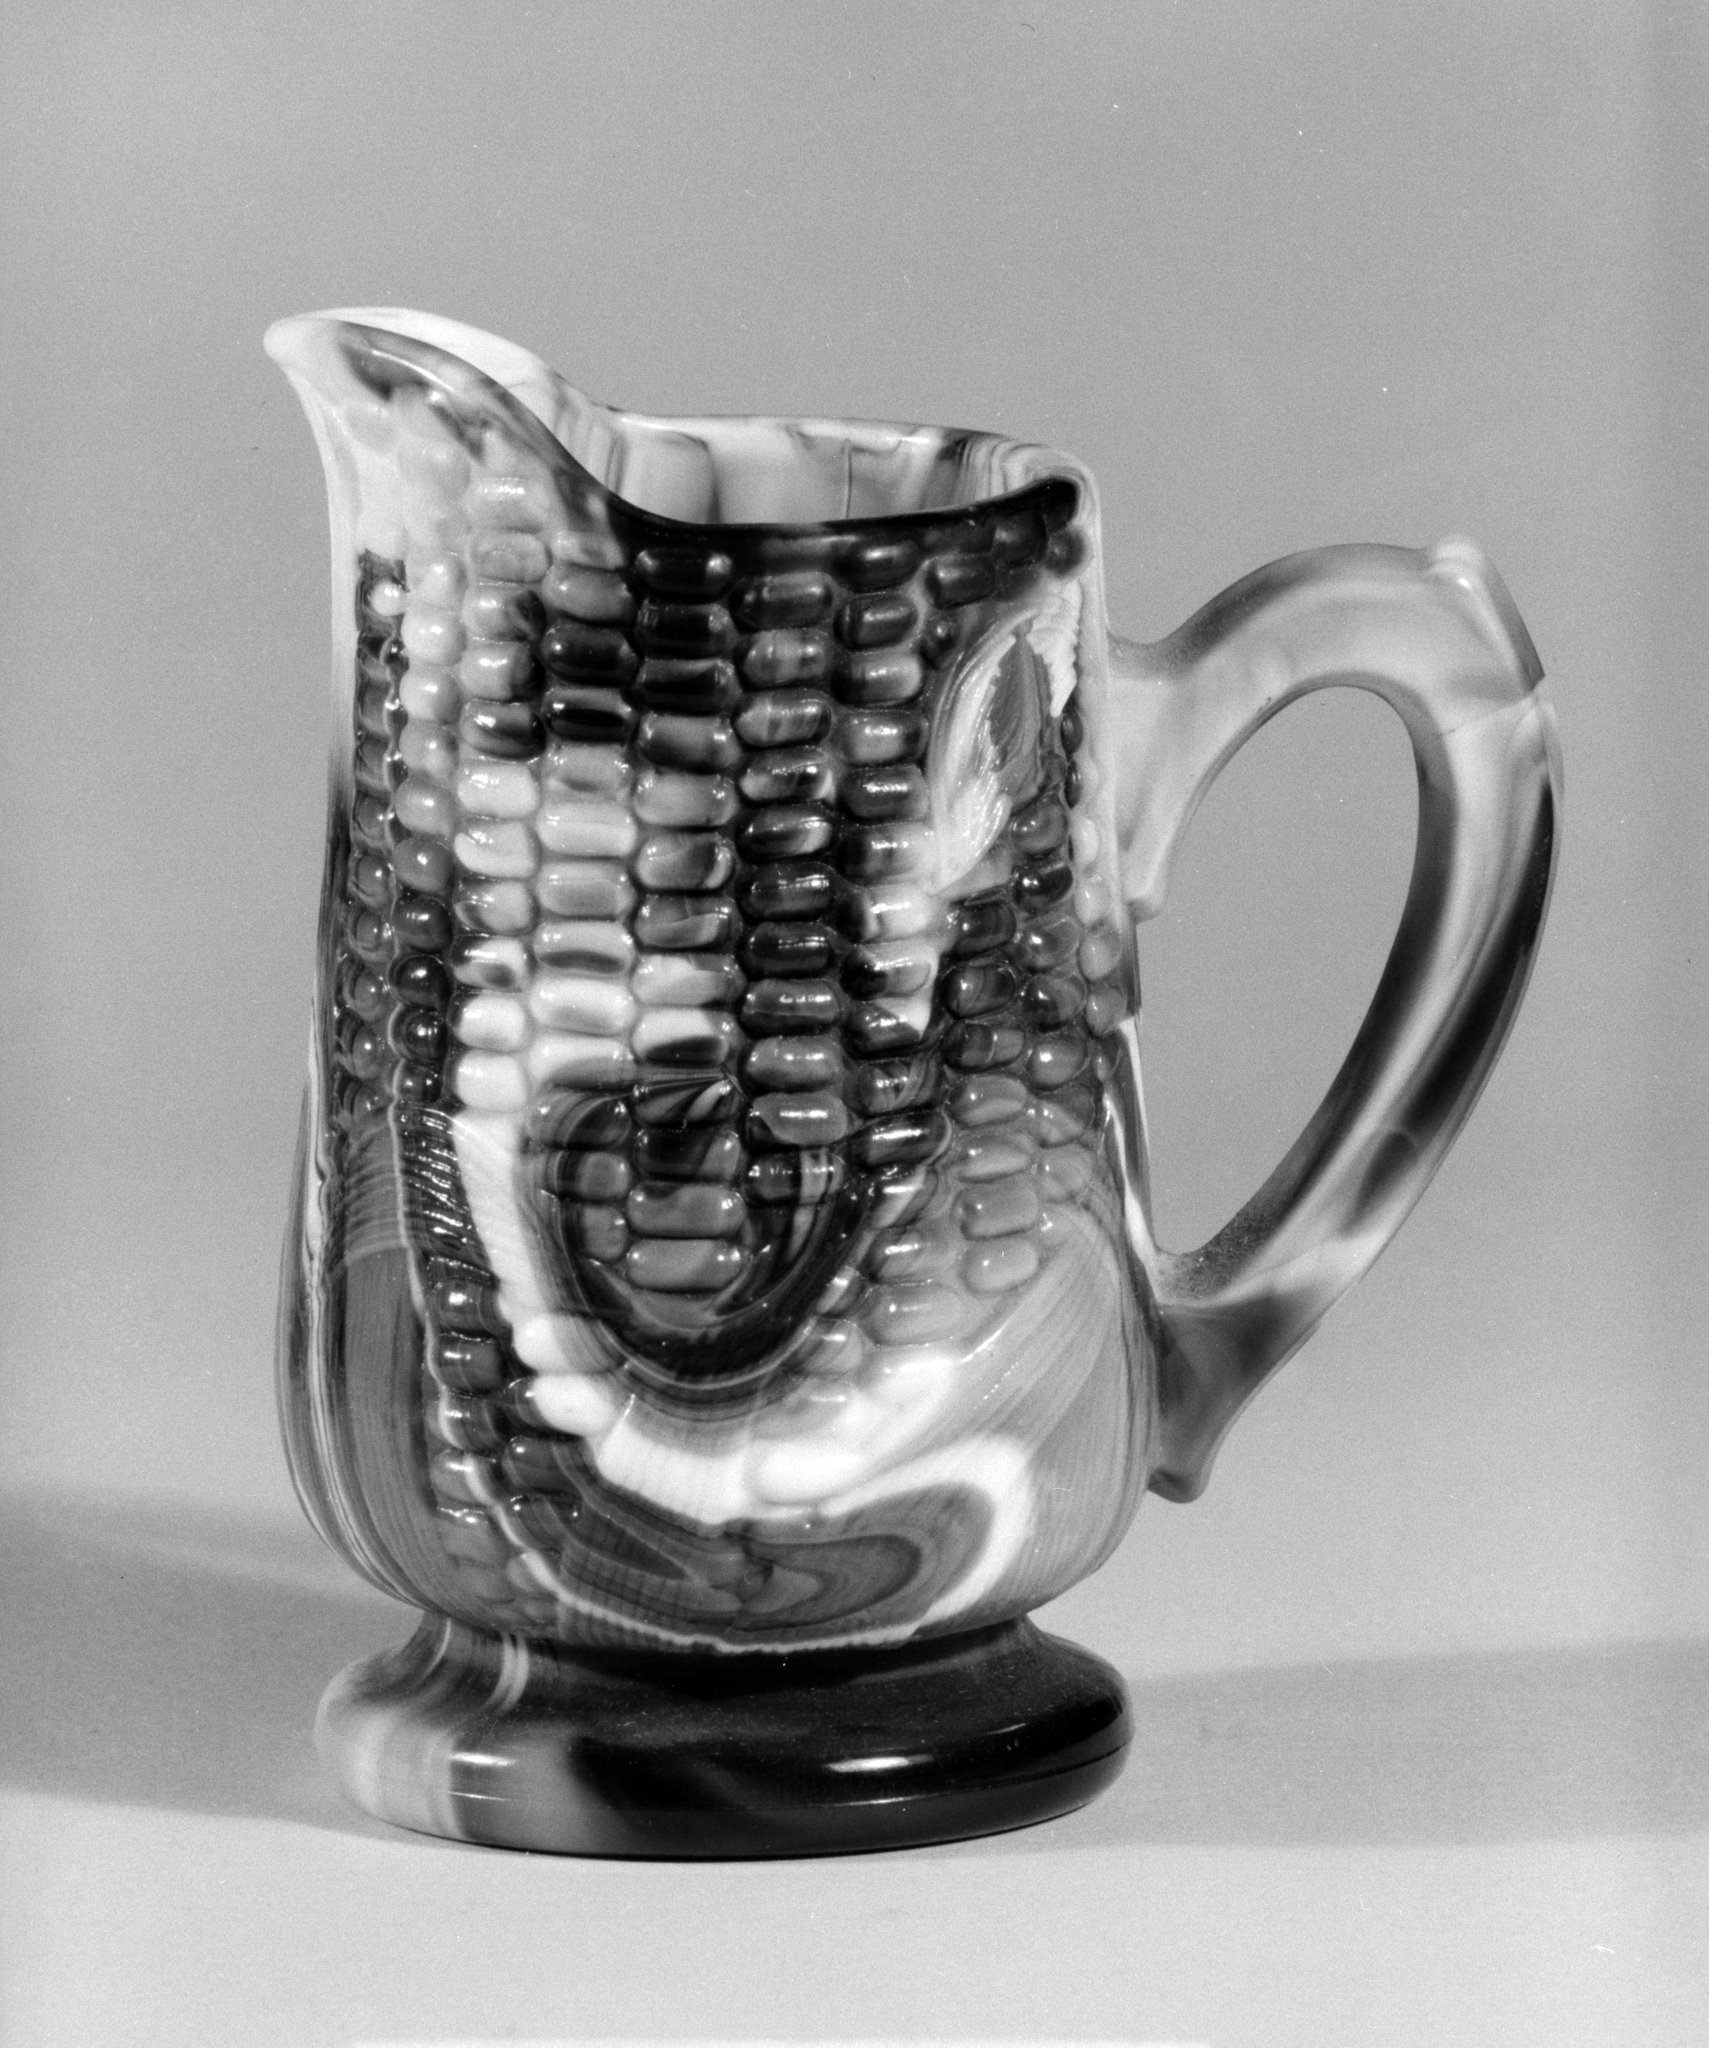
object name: cream pot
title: Creamer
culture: american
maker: challinor, taylor and company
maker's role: maker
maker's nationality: american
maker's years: 1866-1891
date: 1870-1890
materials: glass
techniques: pressed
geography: united states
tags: corn